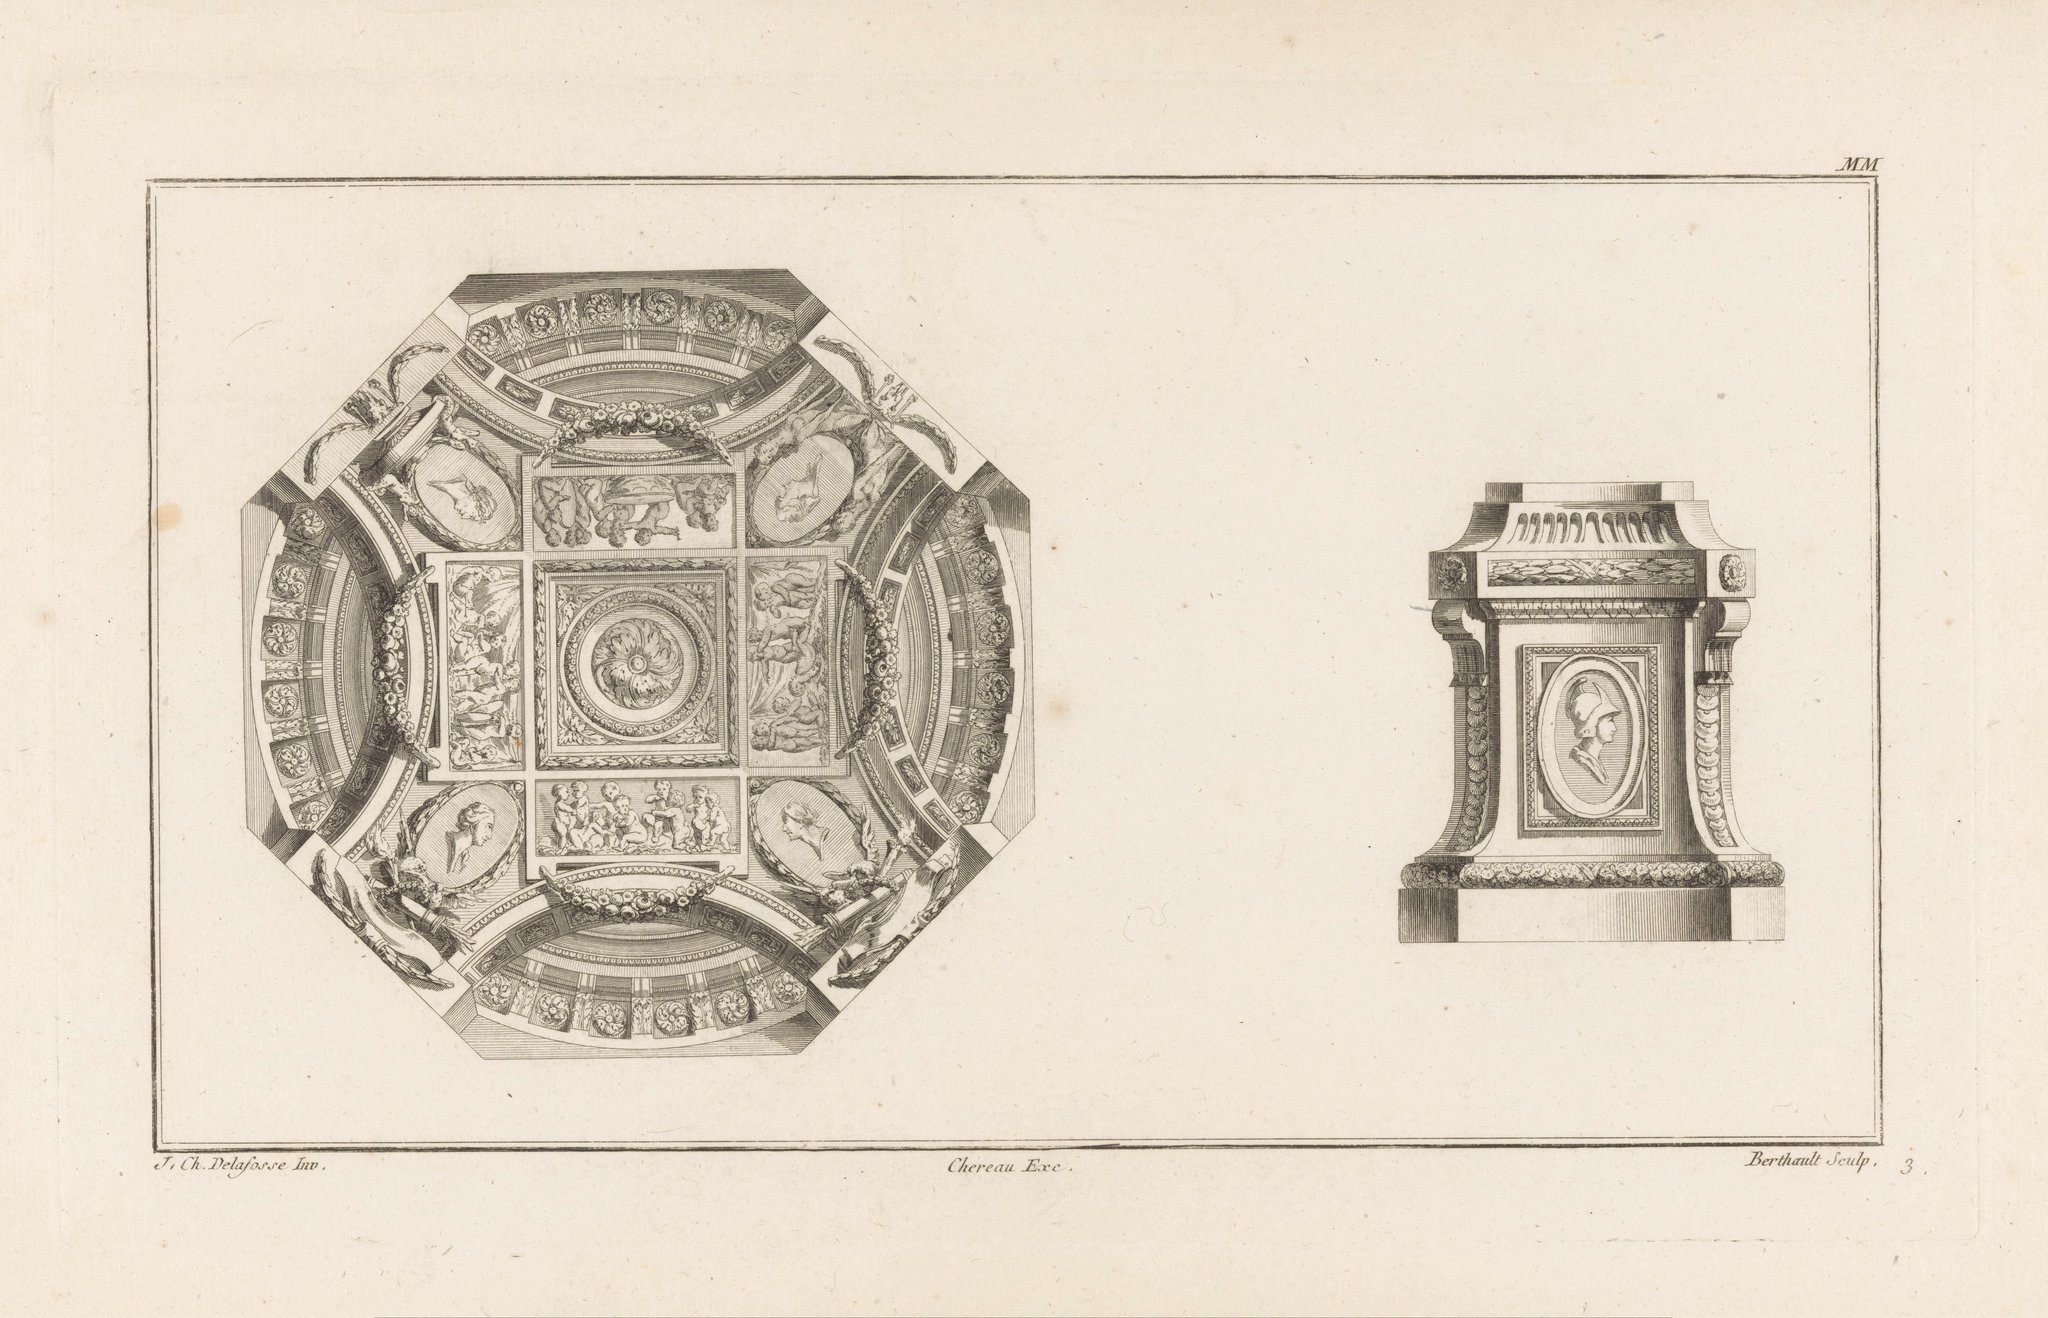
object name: print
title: Plafond en voetstuk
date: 1771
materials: paper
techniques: engraving, etching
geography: paris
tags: pedestal of a piece of sculpture (perhaps in the form of a herm), (decorated) ceiling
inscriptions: collector's mark: Lugt 2228, collector's mark: Lugt 2760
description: Links een rond geornamenteerd plafond met vier ovale medaillons met portretten en profil en in het midden een rozet. Rechts een geornamenteerd voetstuk met een ovaal medaillon met een portret met helm en profil.